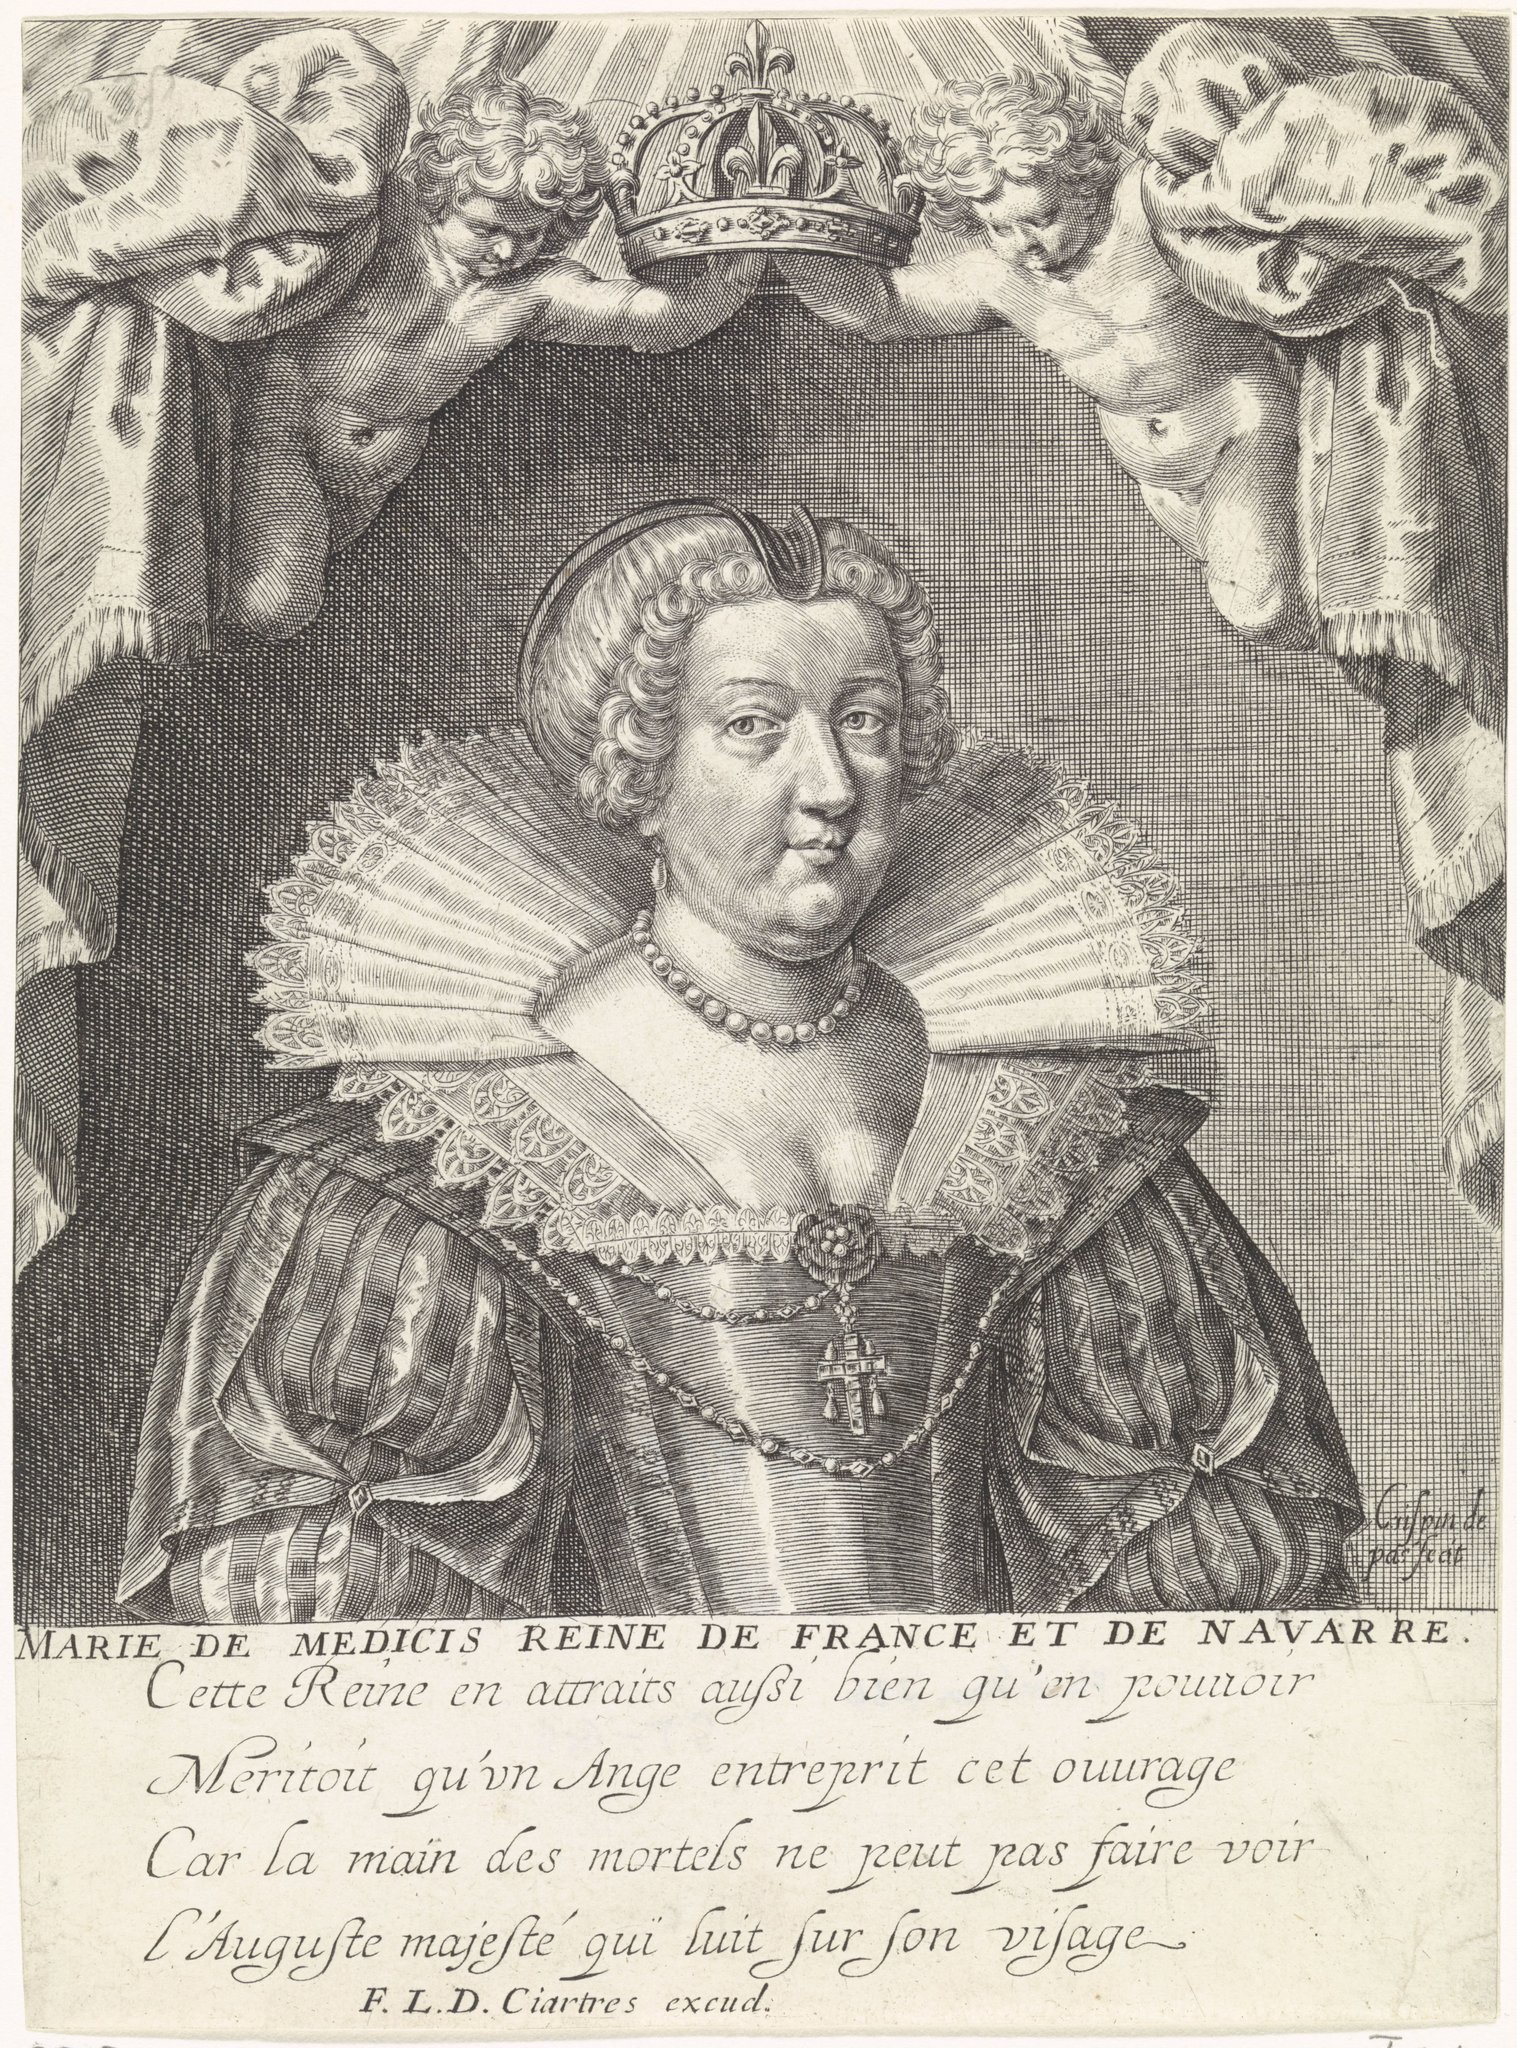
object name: print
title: Portret van Maria de' Medici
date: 1610-1630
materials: paper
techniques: engraving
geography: paris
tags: print maker, maria de' medici, crown (symbol of sovereignty) - bb - female ruler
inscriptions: collector's mark: Lugt 2228, collector's mark: Lugt 2760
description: Portret van Maria de' Medici, koningin van Frankrijk en Navarra, die door twee engelen gekroond wordt. Ze trouwde op 17 december 1600 met de Franse koning Hendrik IV. In de marge de naam en functie van de geportretteerde en een vierregelig lofdicht in het Frans.